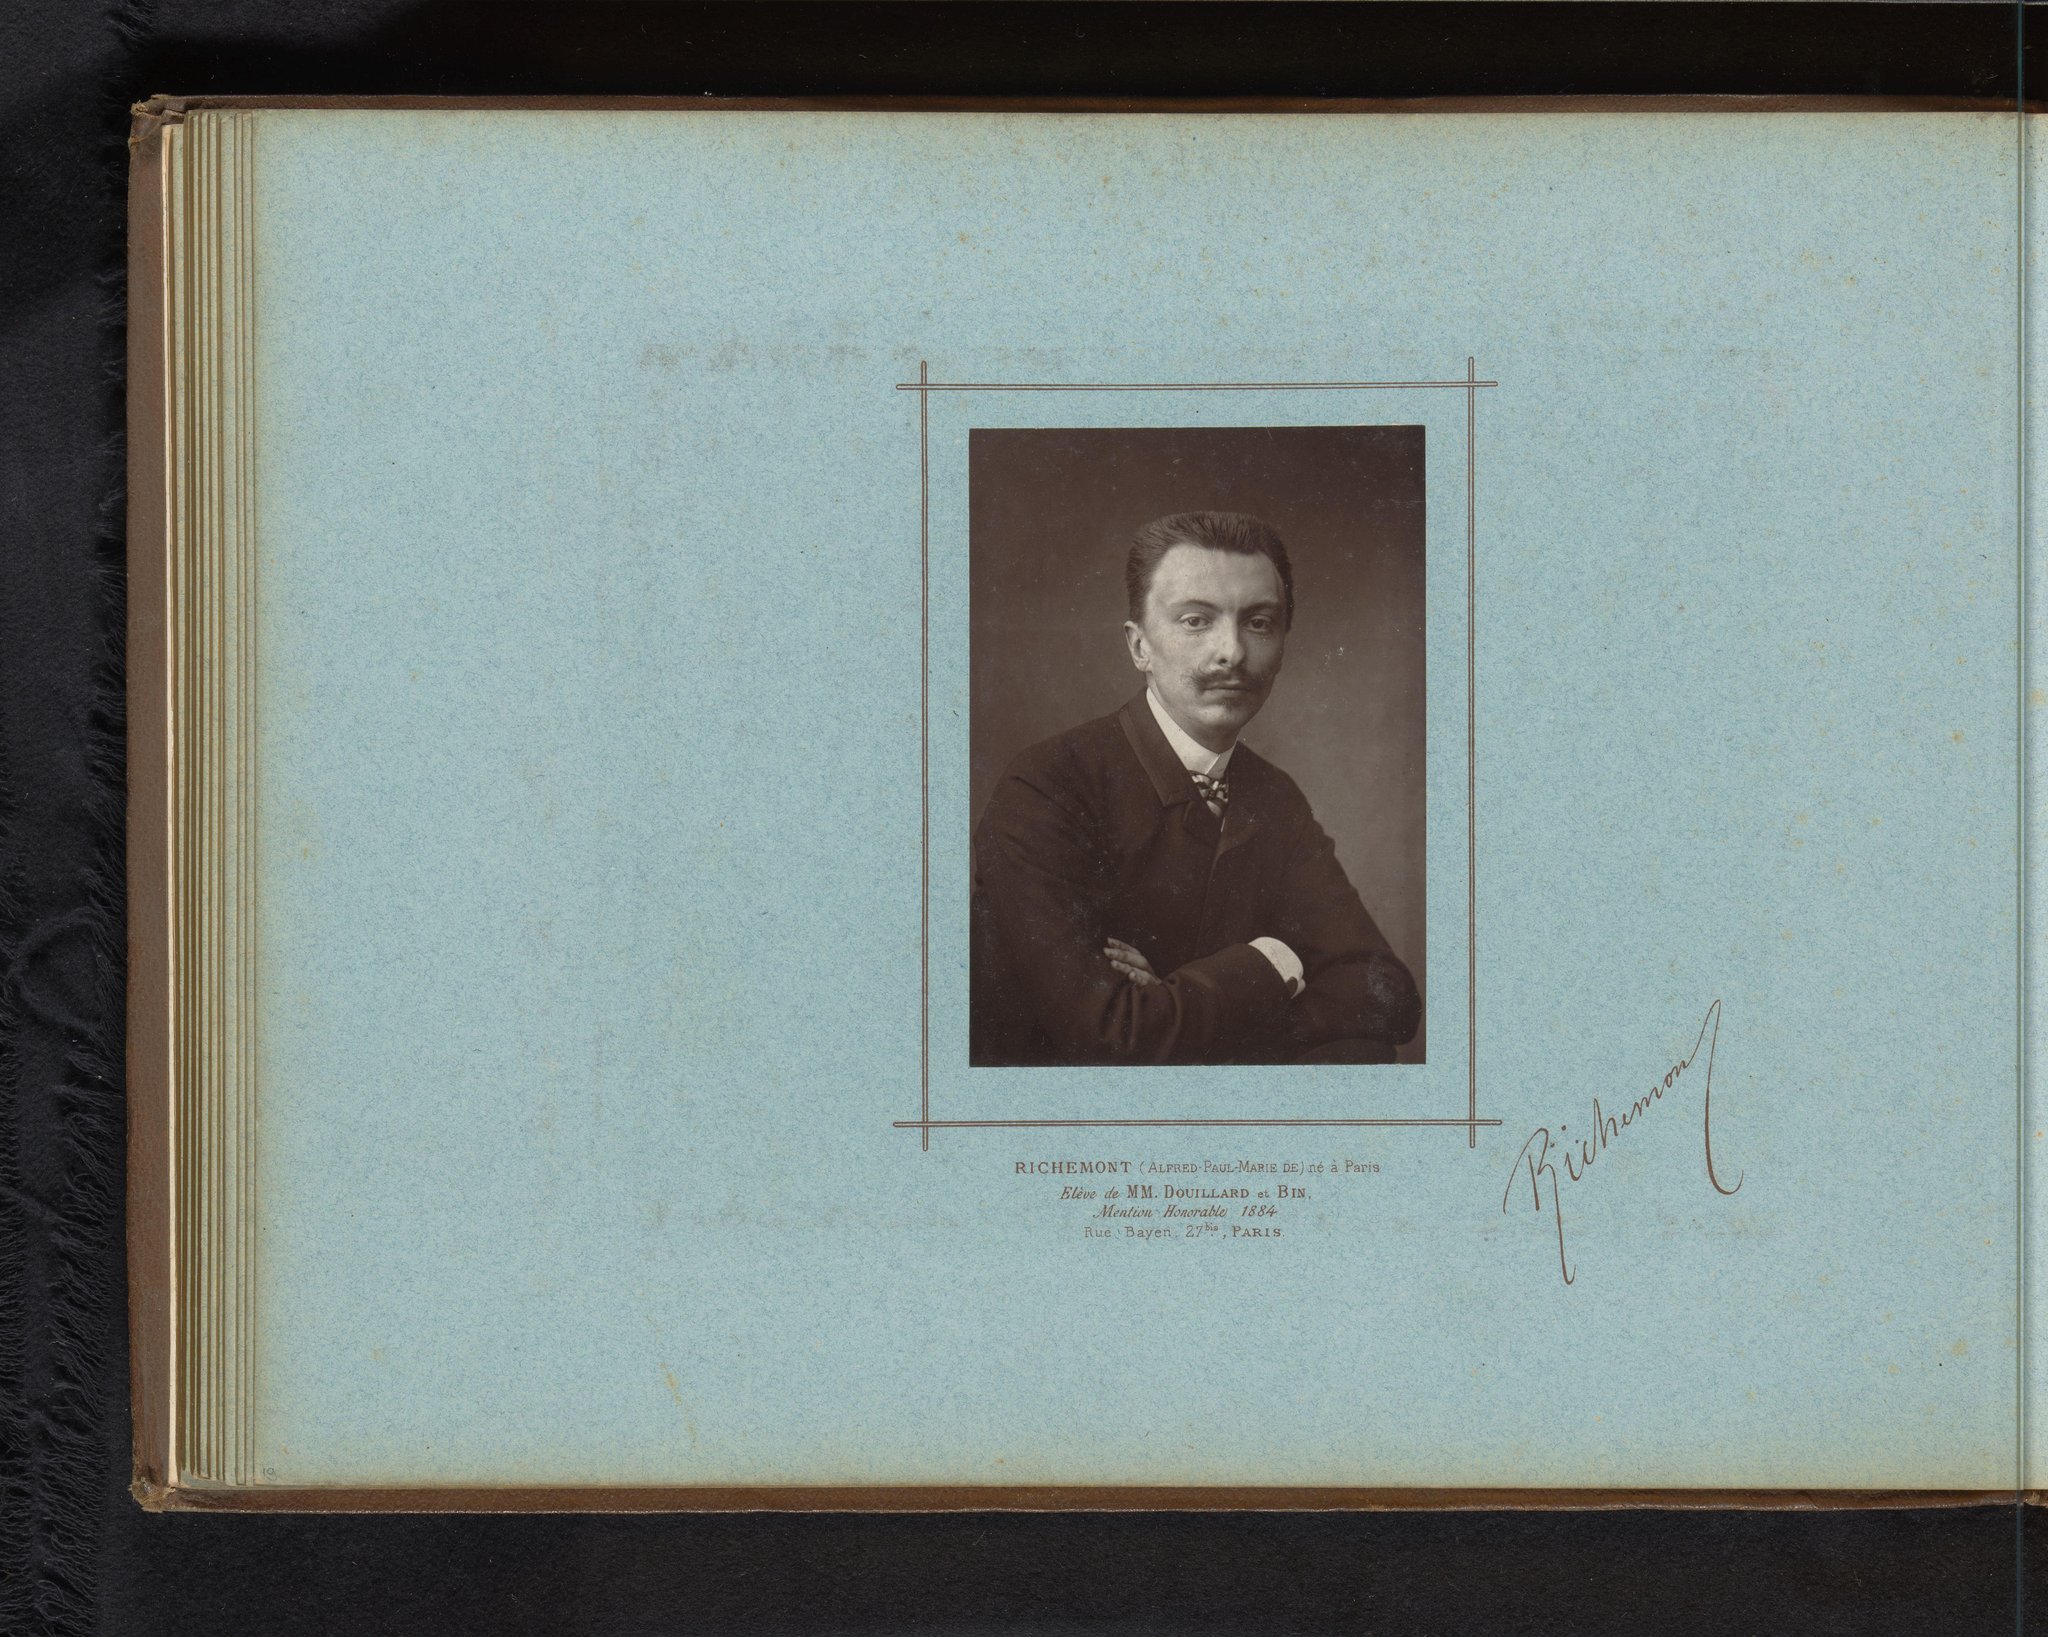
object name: page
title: Portret van Alfred Paul Marie de Richemont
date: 1879-1884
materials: paper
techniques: woodburytype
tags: paris, painter, draughtsman, alfred paul marie de richemont, historical persons, portrait, self-portrait of painter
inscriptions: signature: ‘Richemont’, inscription: ‘RICHEMONT (Alfred-Paul-Marie de) né à Paris/ Elève de M.M. Douillard et Bin,/ Mention Honorable 1884/ Rue Bayen, 27bis, Paris.’